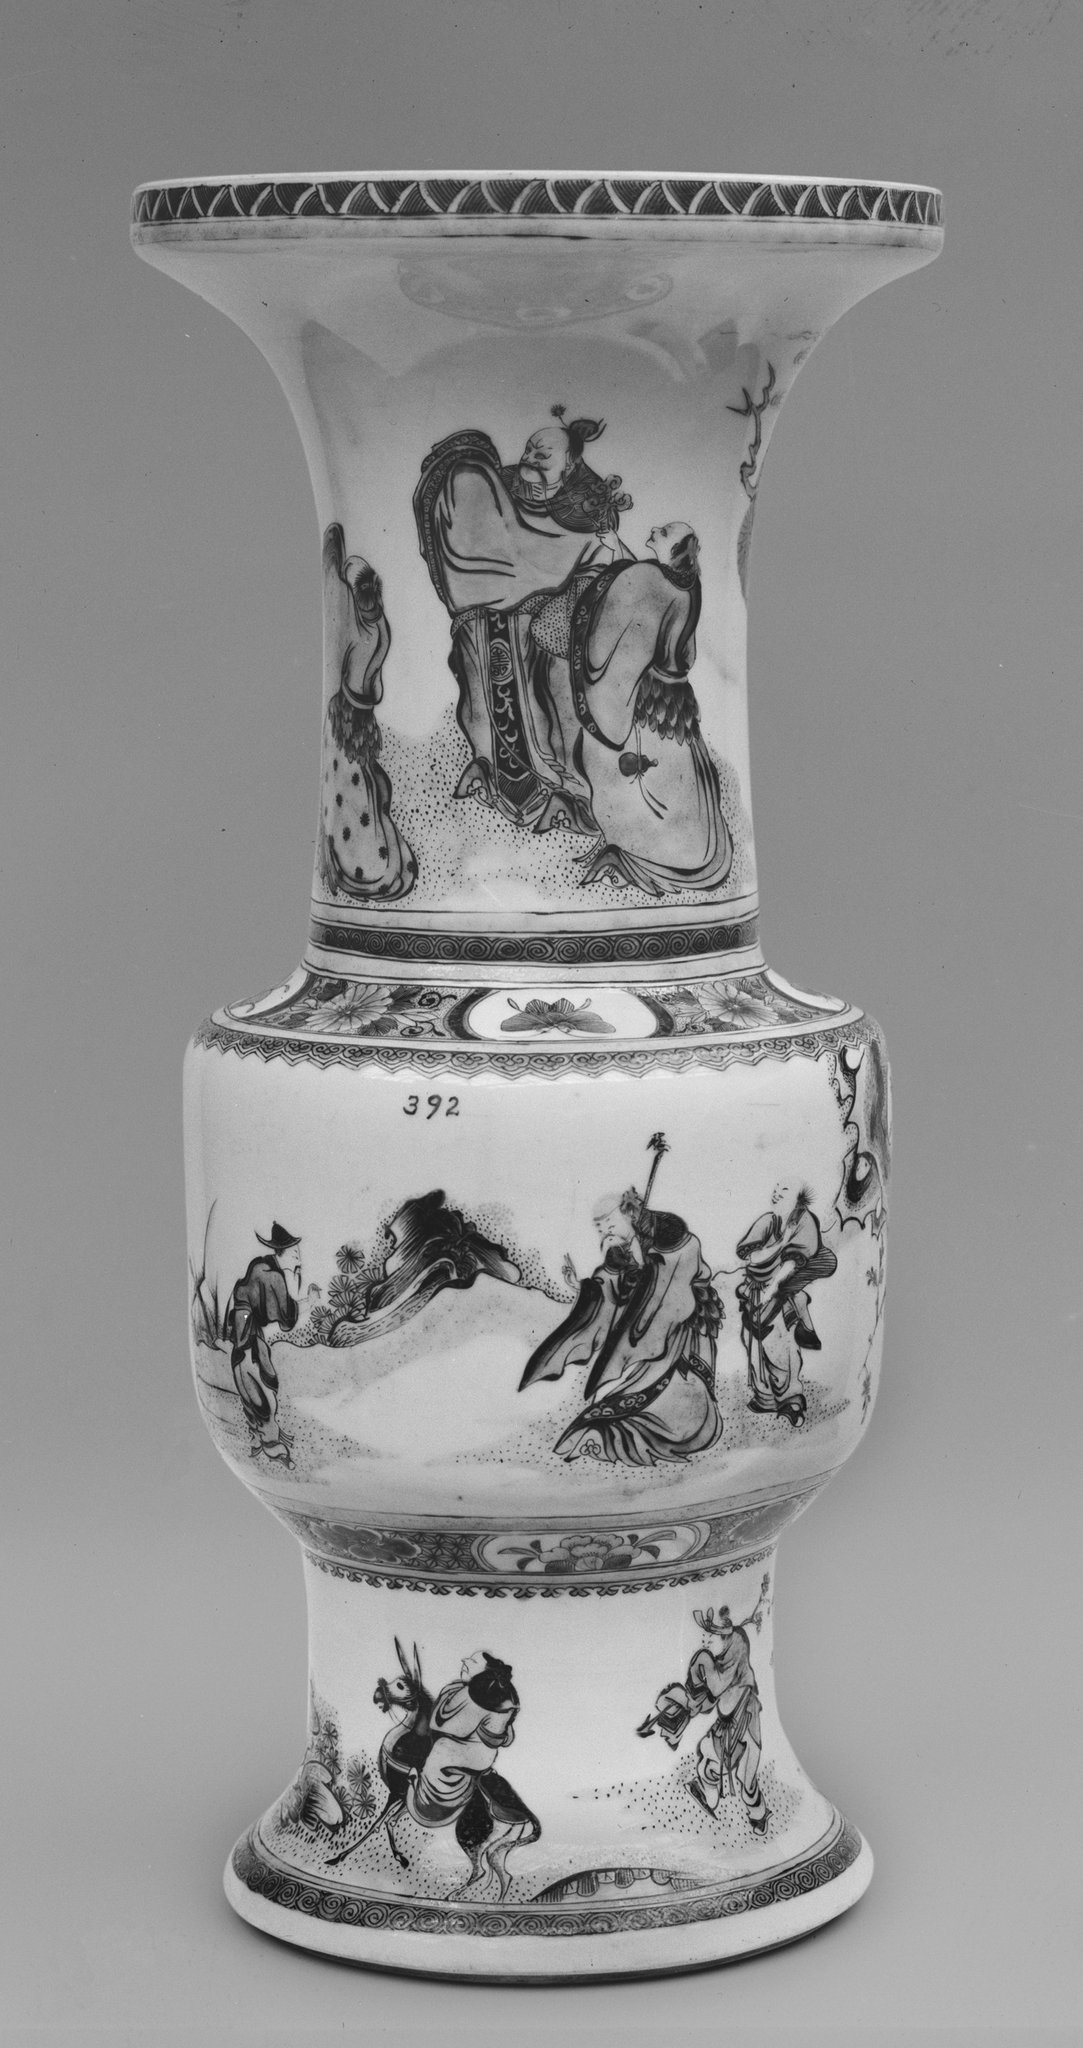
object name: vase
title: Vase with figures in a landscape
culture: chinese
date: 1801-1900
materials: enamel, porcelain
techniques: overglaze, painting, polychrome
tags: men,horses